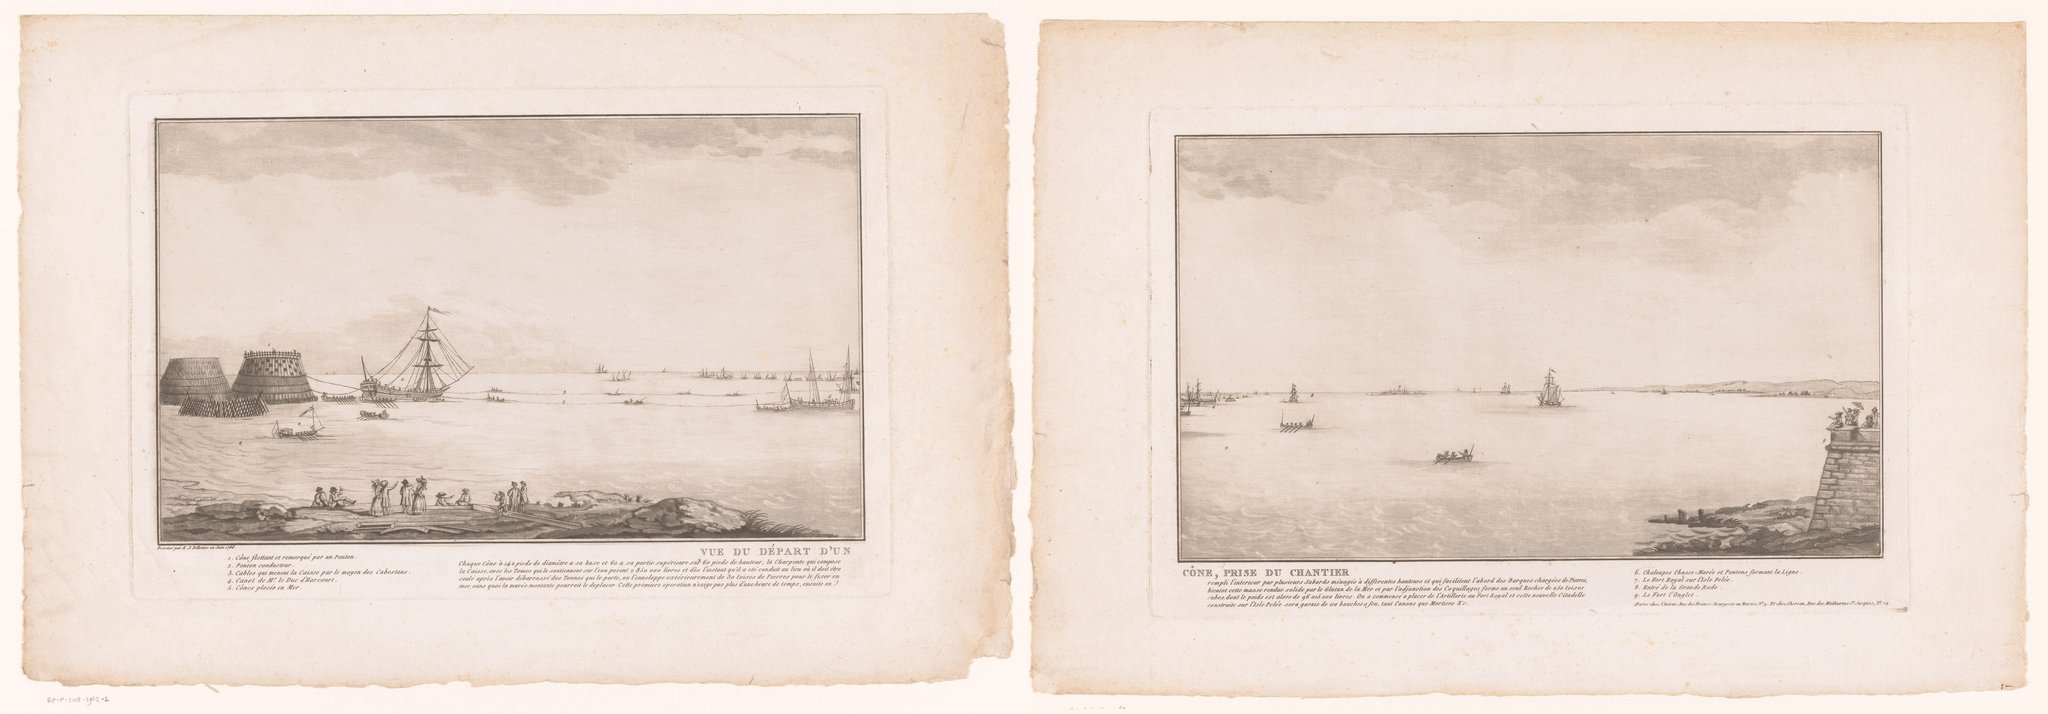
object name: print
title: Vertrek van een boot bij de scheepswerf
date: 1786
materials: paper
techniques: aquatint, etching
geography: paris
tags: harbour, pier, quay, wharf, france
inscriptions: collector's mark: Lugt 2228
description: Dit object is omwille van een betere presentatie virtueel samengevoegd, maar bestaat fysiek uit losse onderdelen.